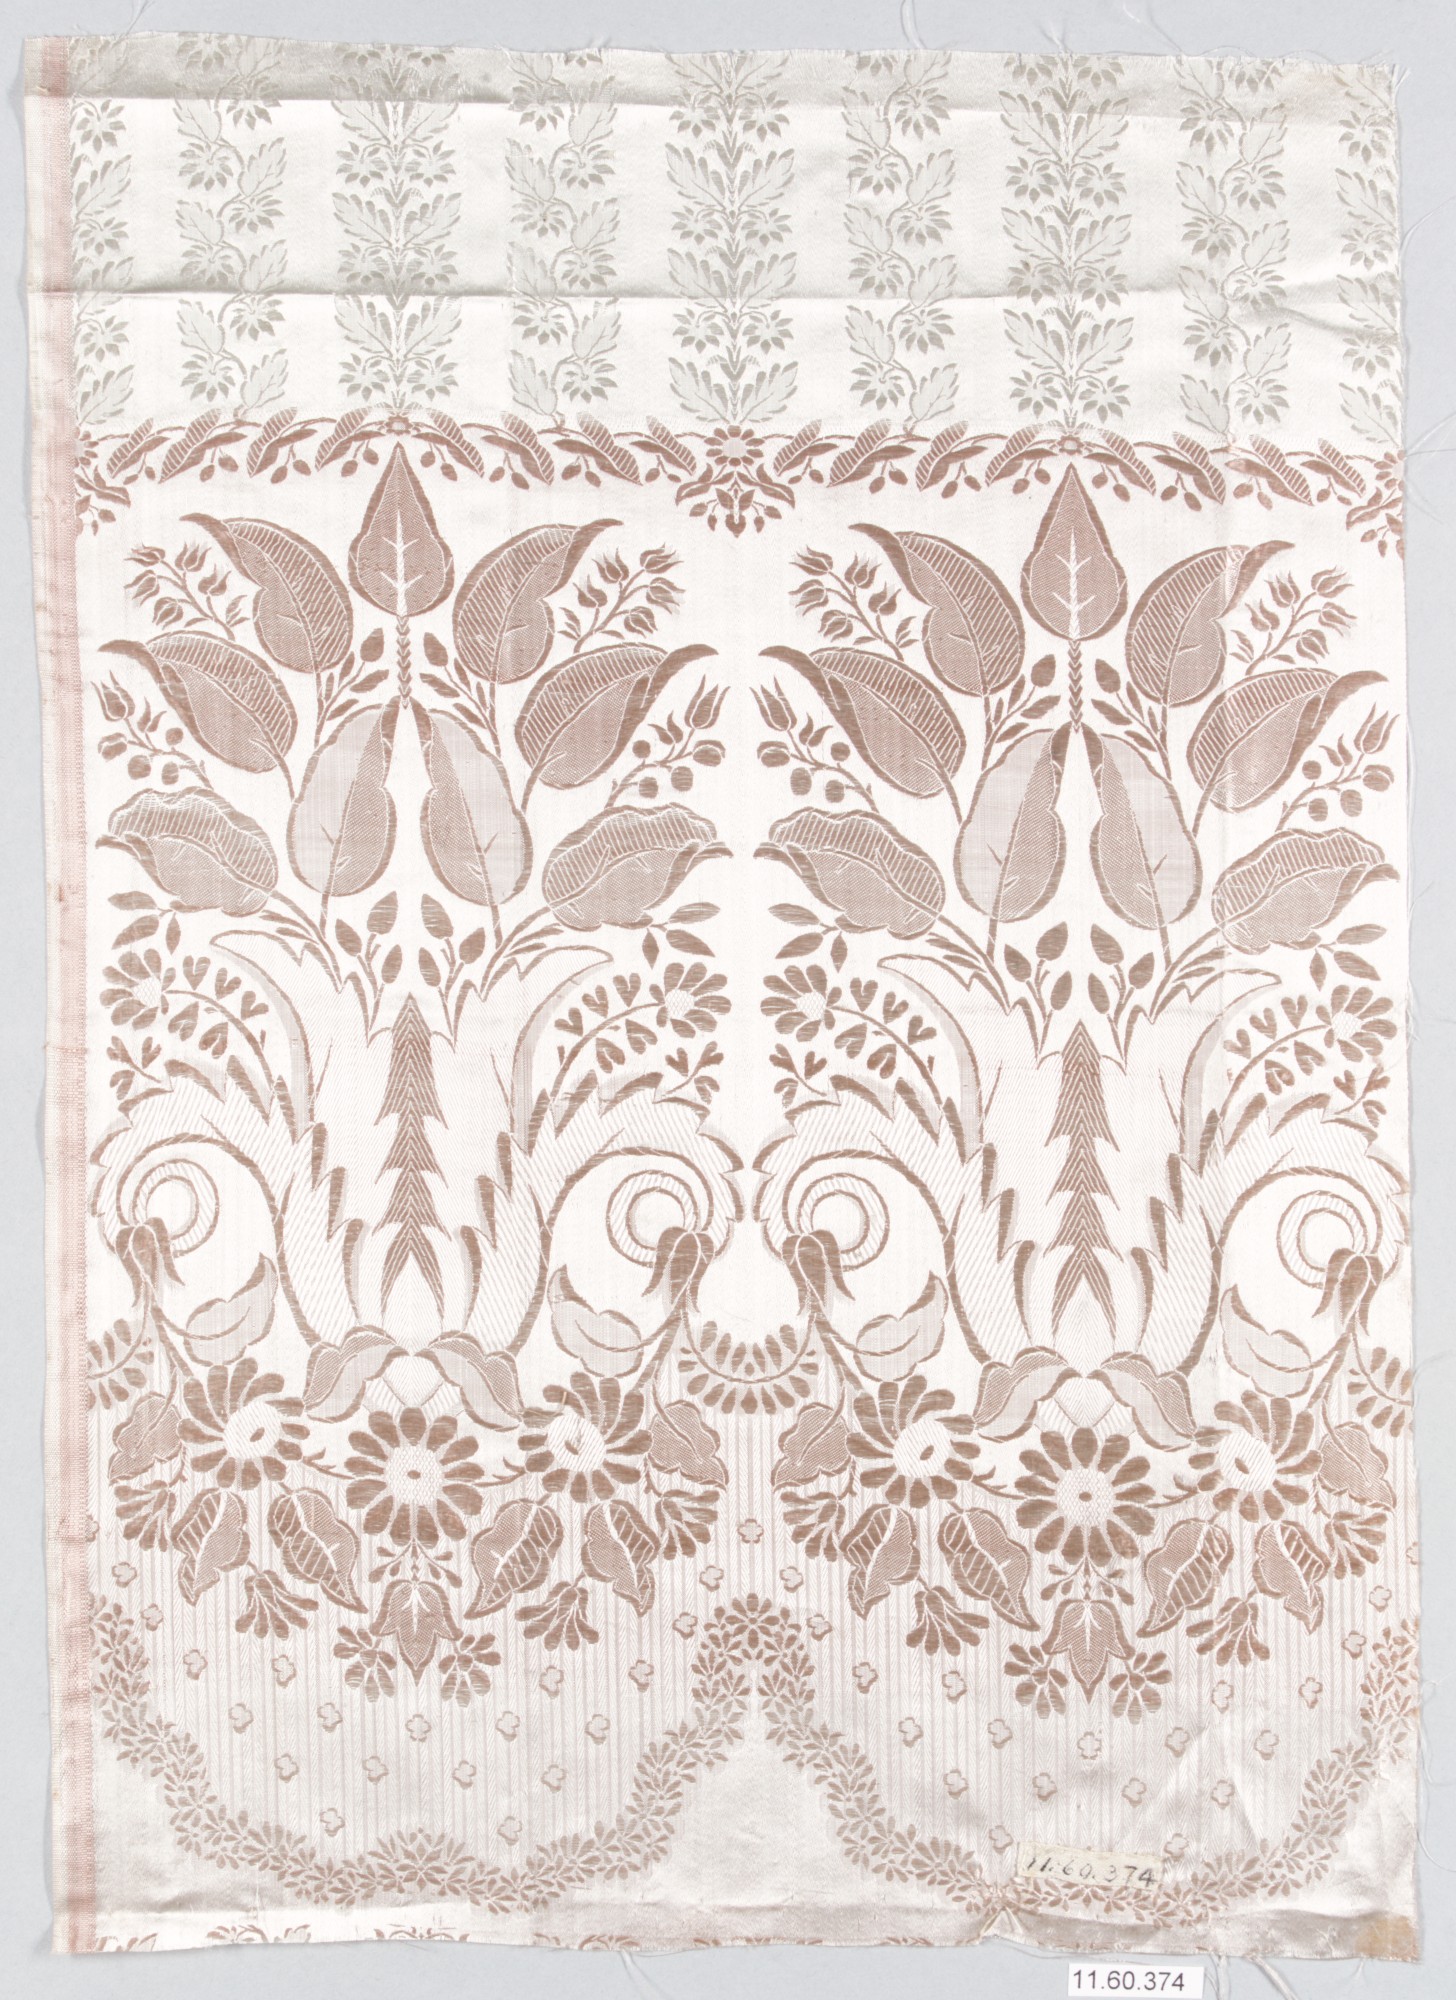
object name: fragment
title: Fragments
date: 1801-1900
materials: silk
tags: flowers,leaves